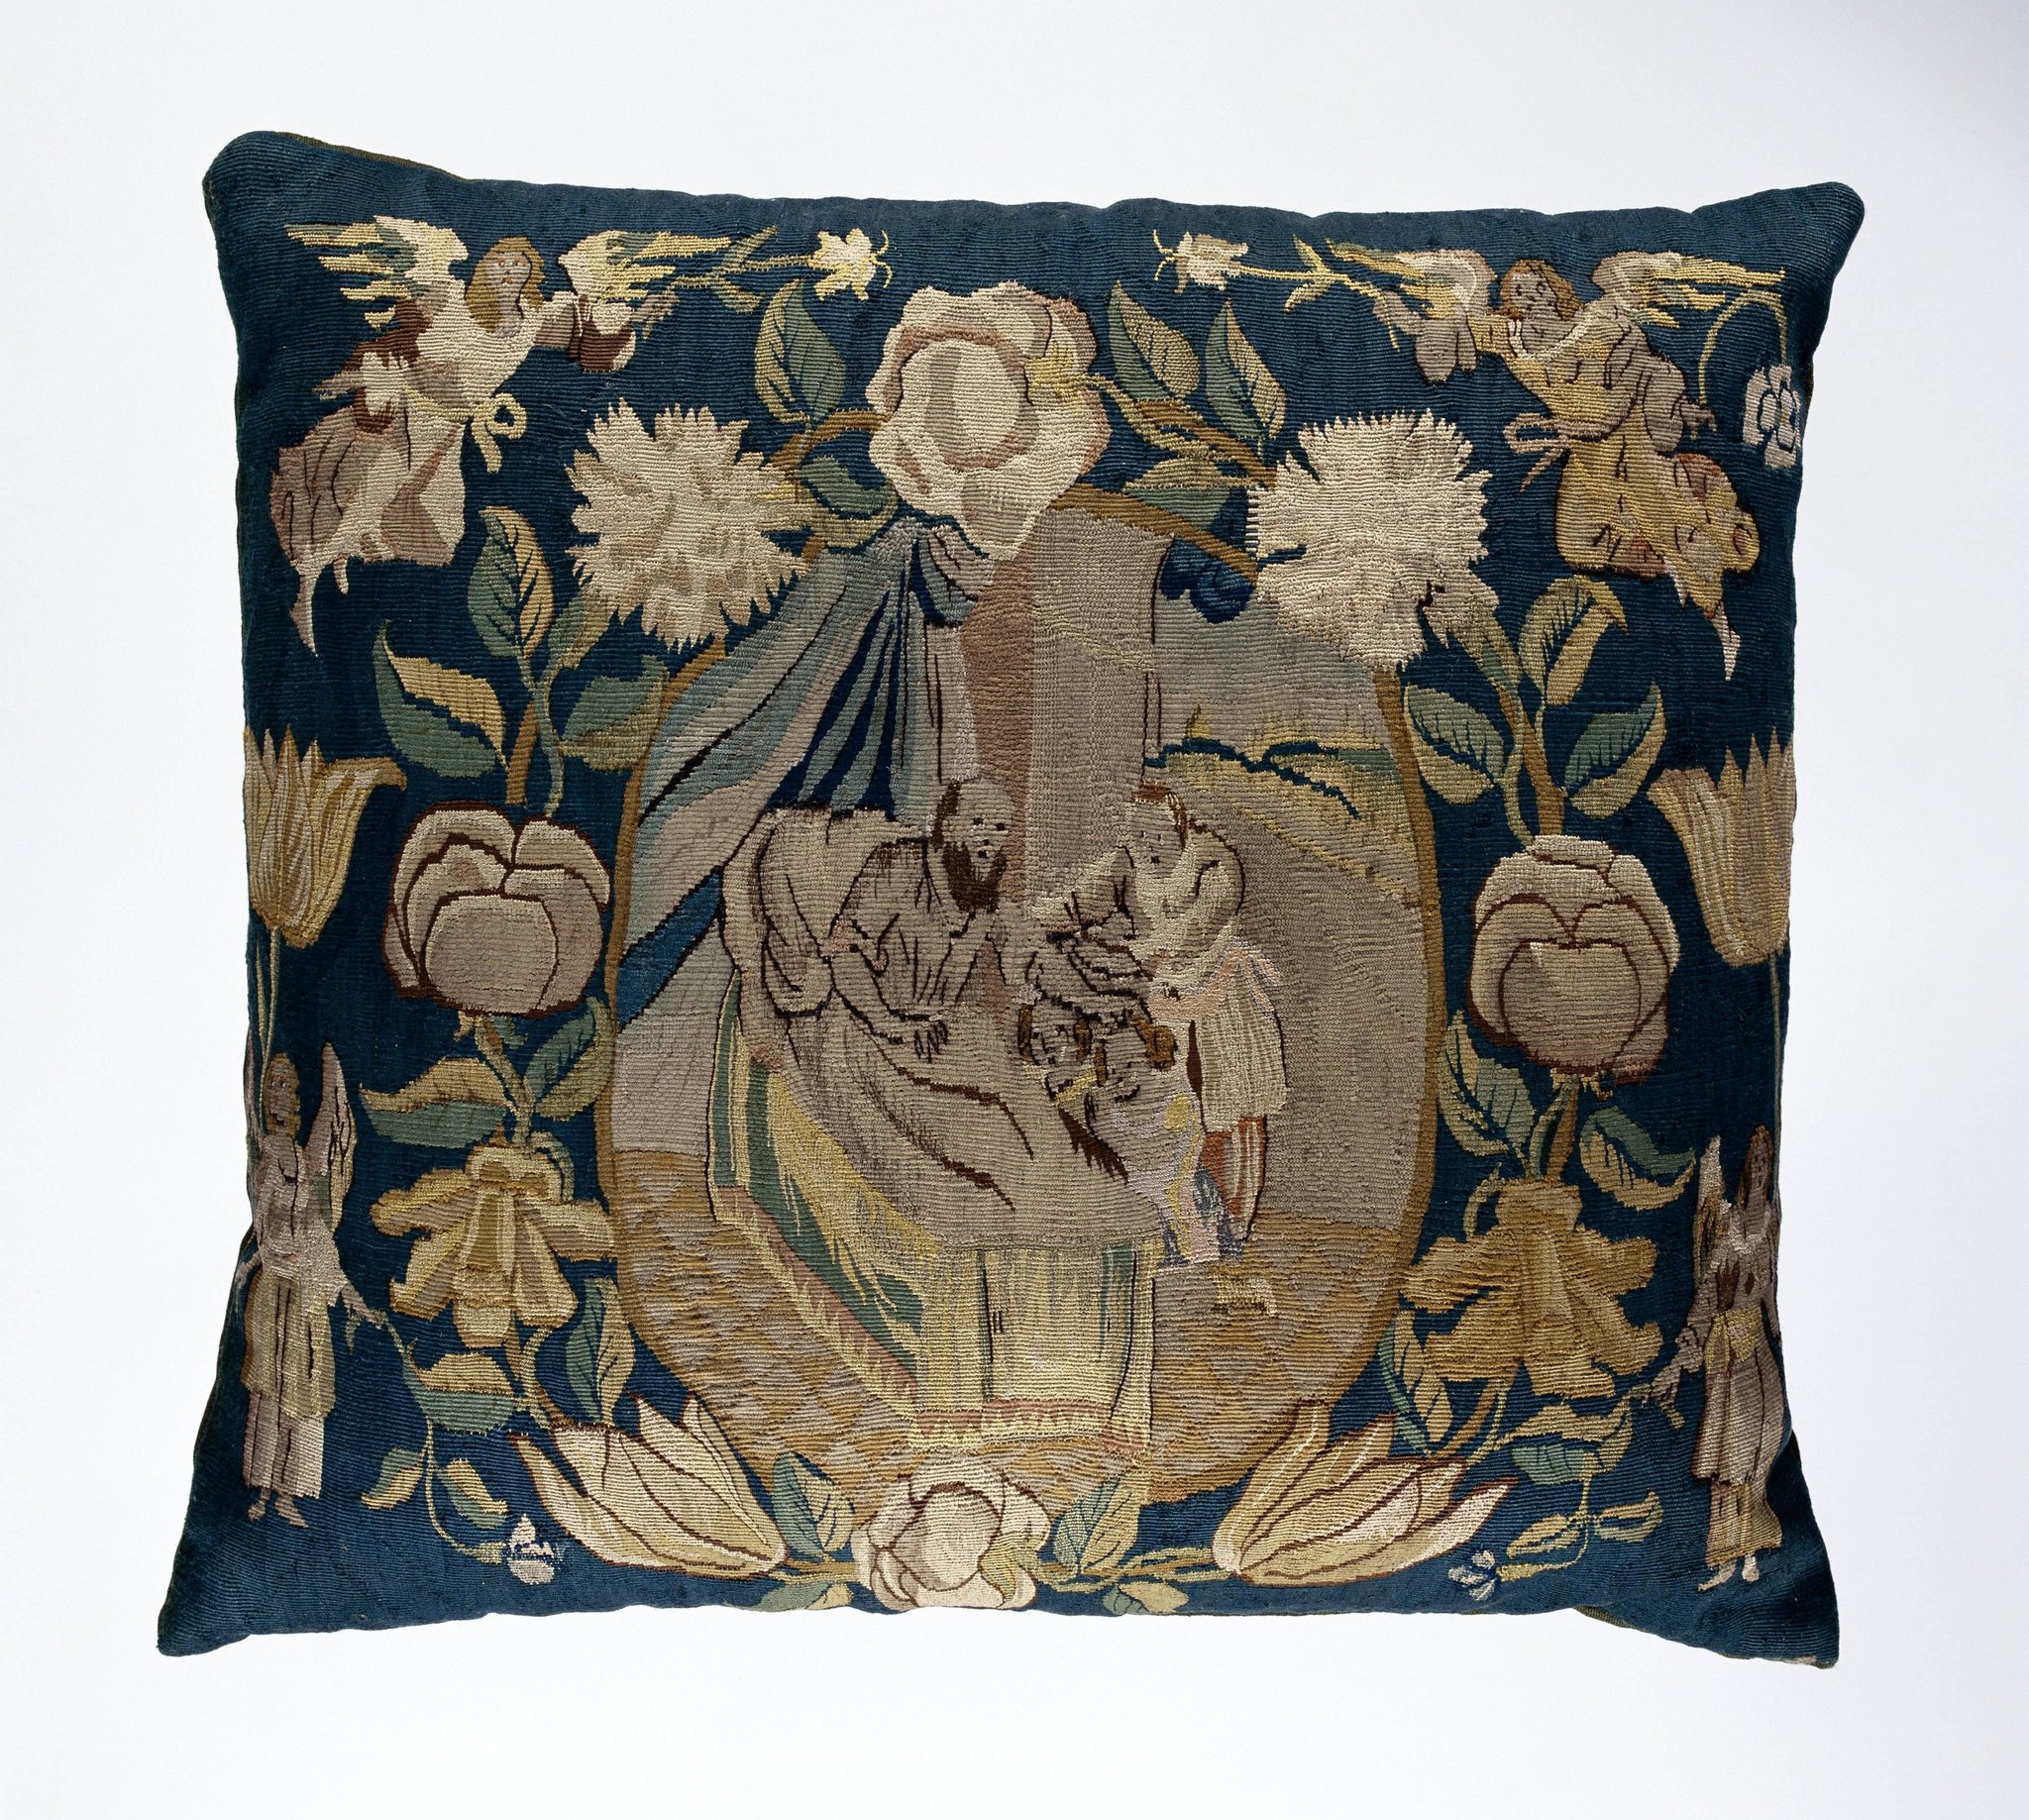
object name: pillow sham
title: De geschiedenis van Jacob, binnen een bloemenkrans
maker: Anonymous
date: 1660-1675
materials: silk, wool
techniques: tapestry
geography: northern netherlands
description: Kussen van tapijtweefsel met Isaac zegent Jacob (Gen. 27:27-29). Het kussen maakt deel uit van een serie kussens met de geschiedenis van Jacob, waarvan twee andere zich in het Rijksmuseum bevinden.